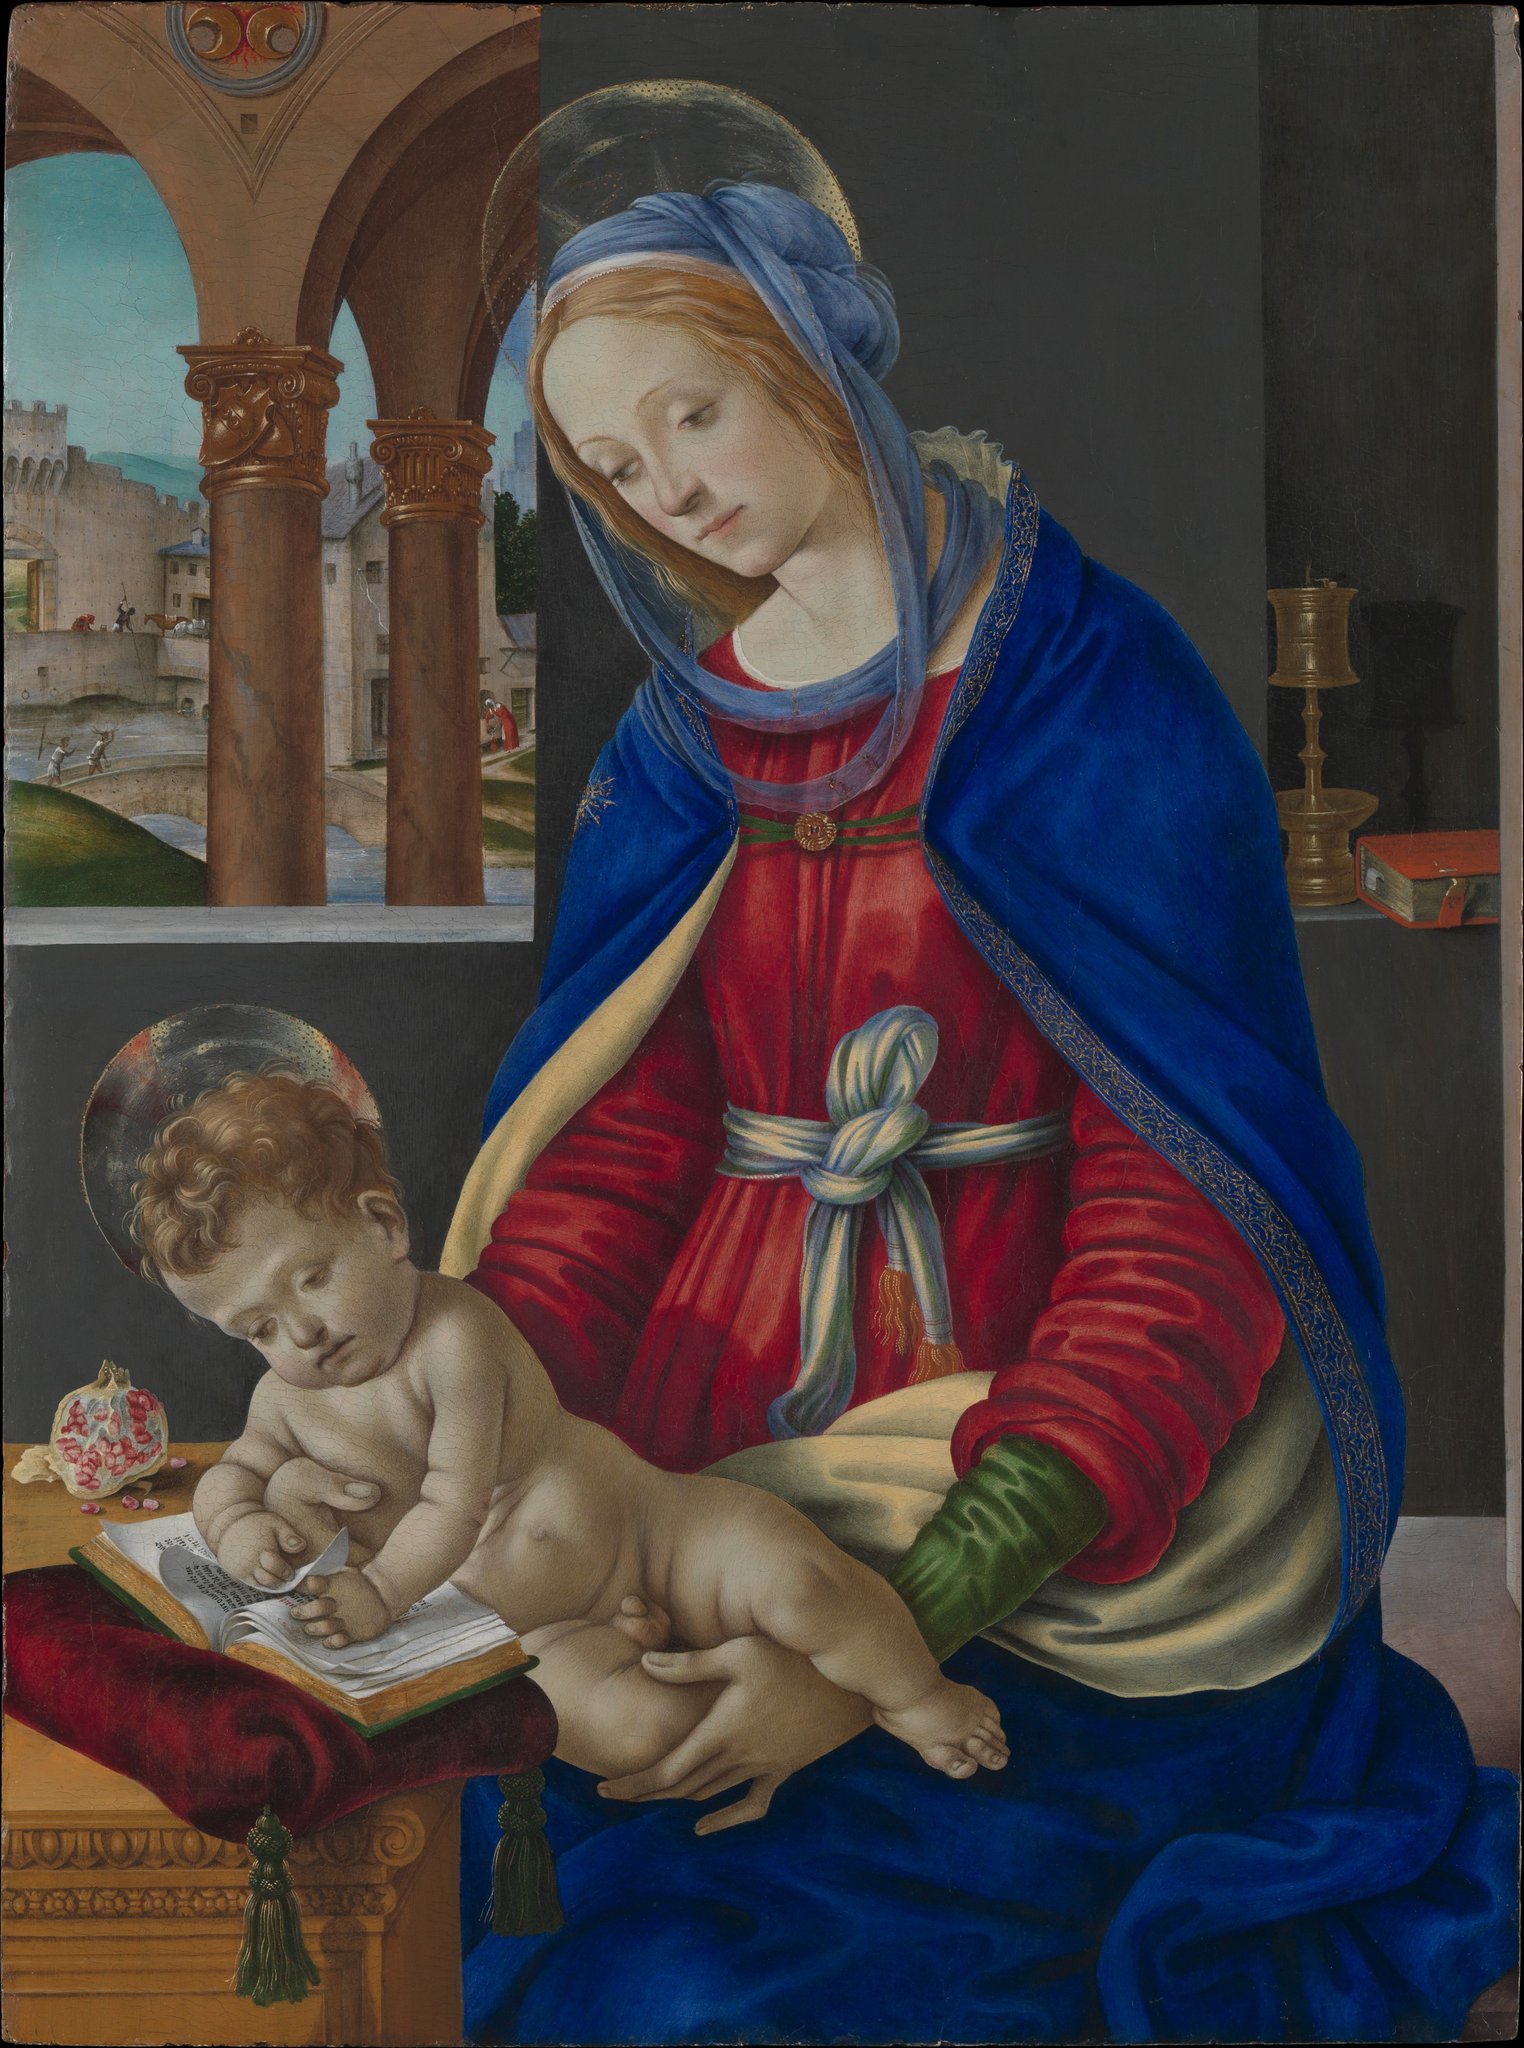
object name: painting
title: Madonna and Child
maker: filippino lippi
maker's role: artist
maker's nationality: italian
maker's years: 1457-1504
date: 1483-1484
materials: gold, oil, paint, wood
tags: madonna and child